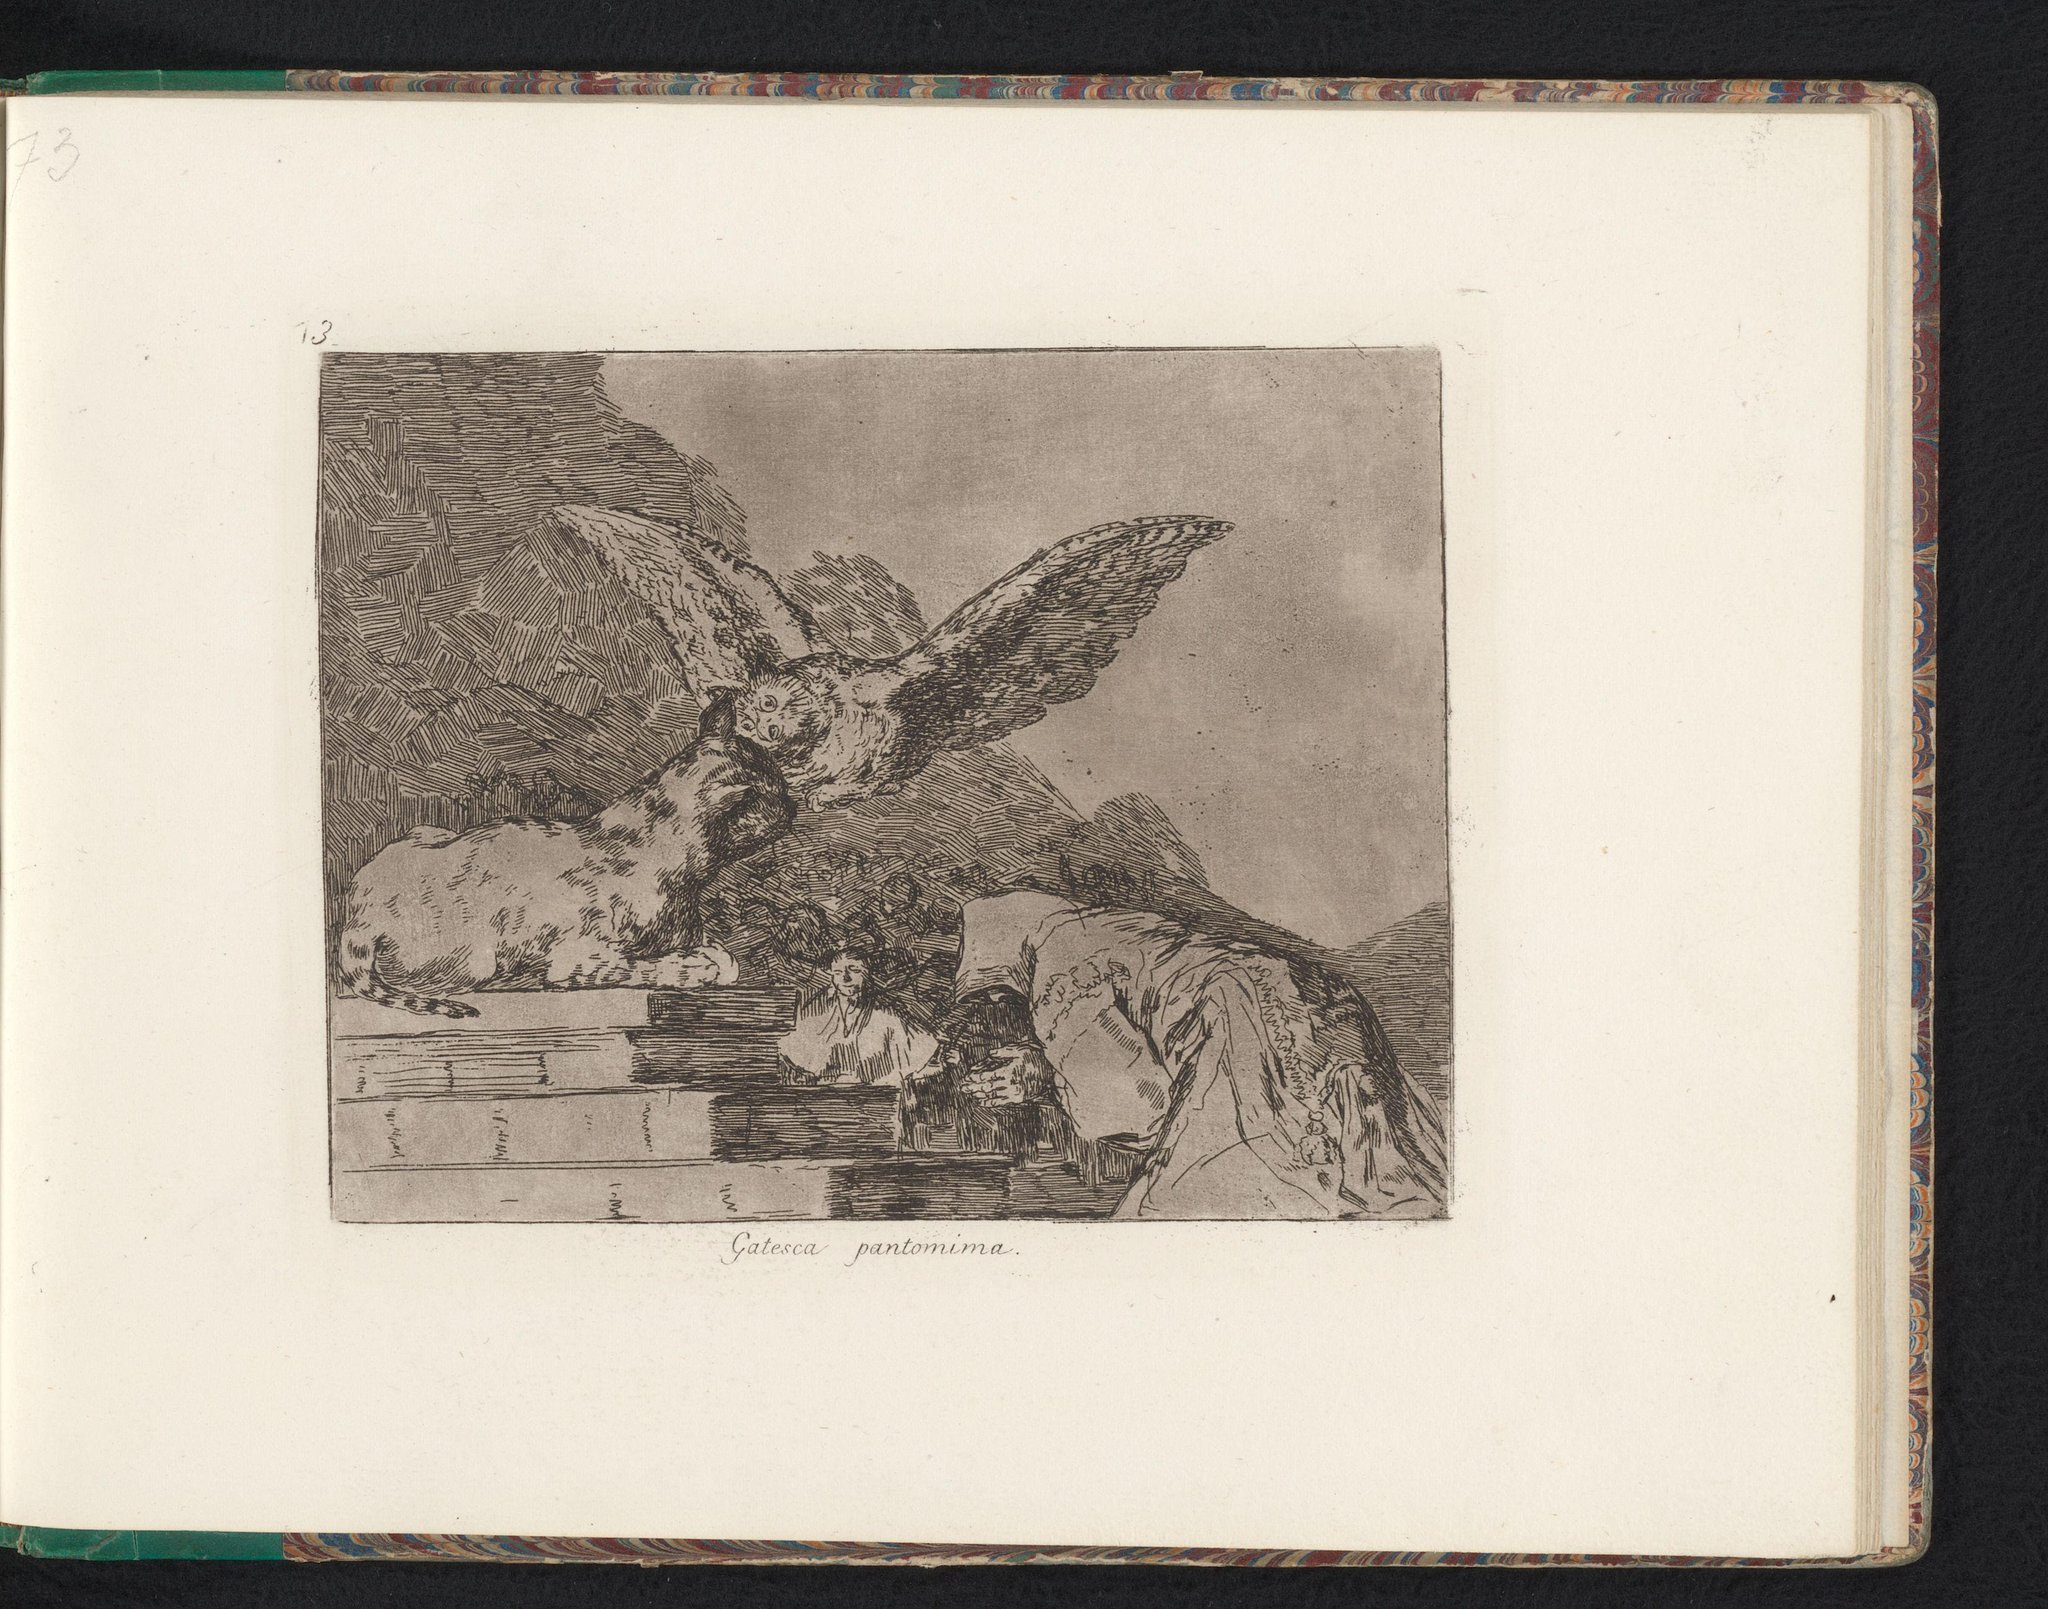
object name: album leaf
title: Los desastres de la guerra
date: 1810-1820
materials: paper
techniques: engraving, etching, intaglio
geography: madrid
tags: (public) prayer, cat, owls, horrors of war, spain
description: Deze prent maakt deel uit van een album.